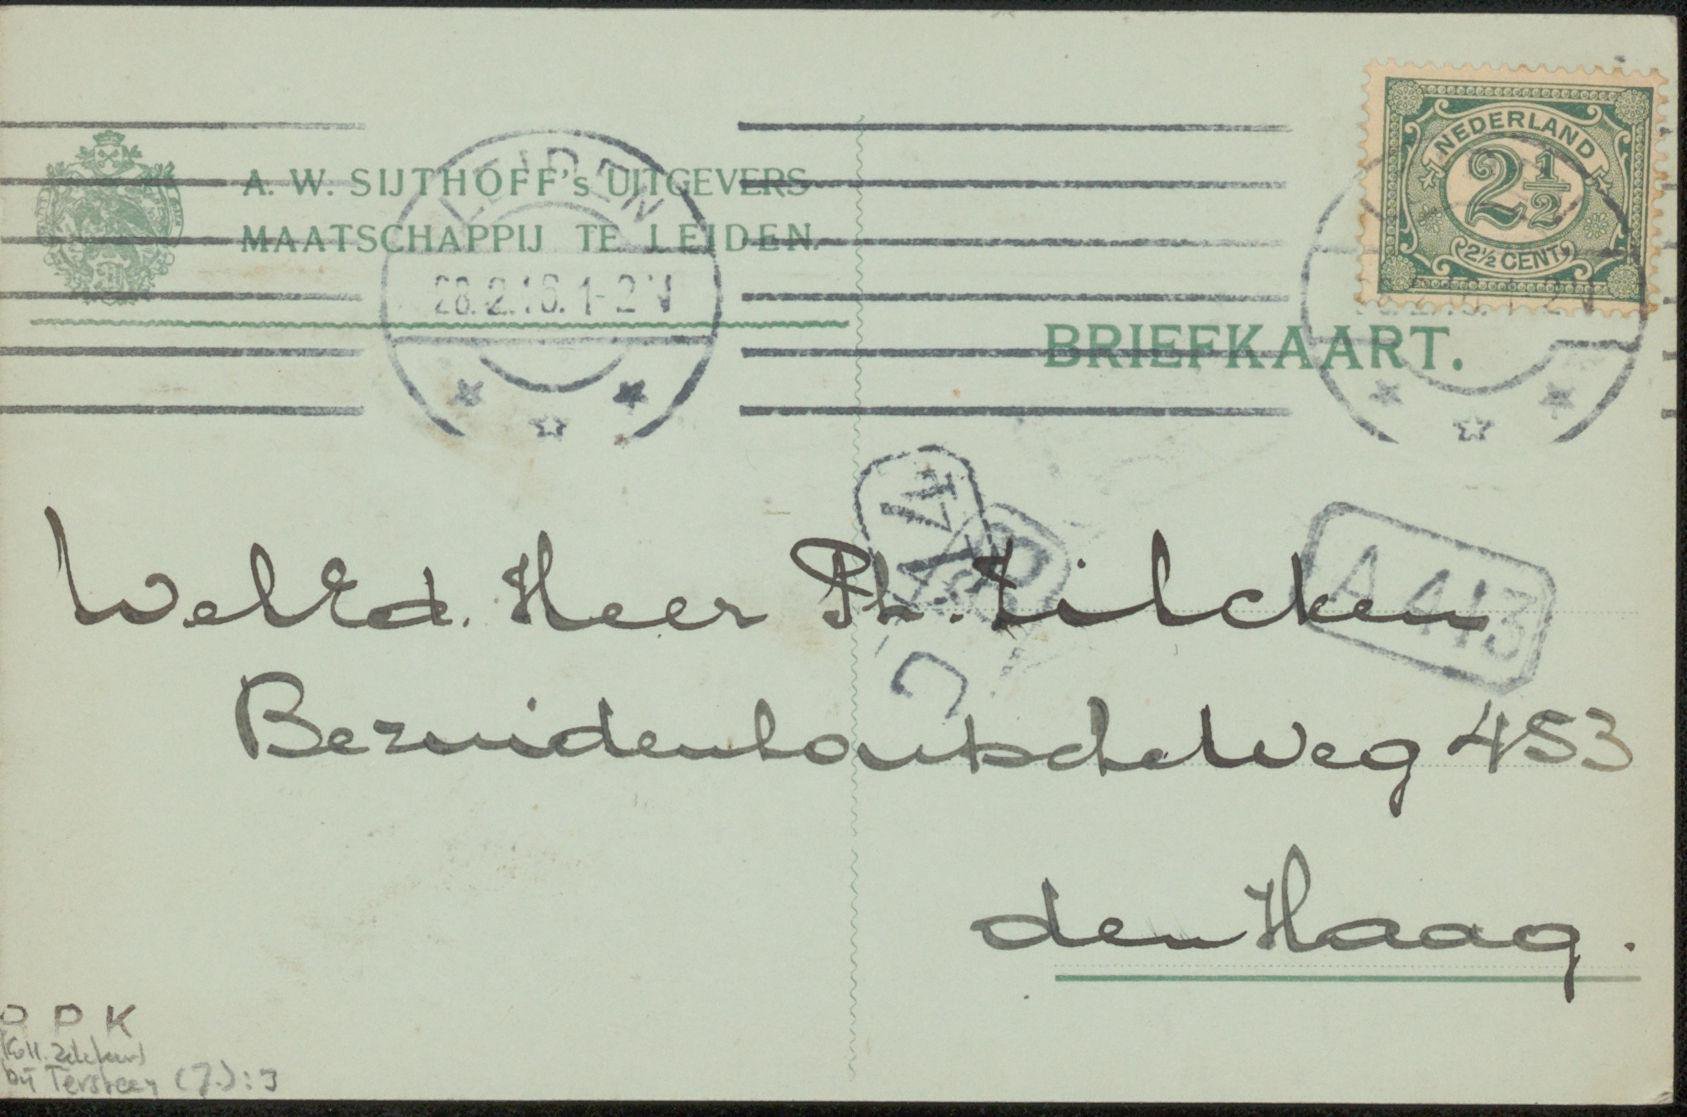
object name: postcard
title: Briefkaart aan Philip Zilcken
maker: johan tersteeg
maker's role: redacteur, schrijver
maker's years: 1873-1953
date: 1916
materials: cardboard, ink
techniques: pen, writing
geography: leiden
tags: painter, philip zilcken, photography, cinematography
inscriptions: collector's mark: ‘RPK’